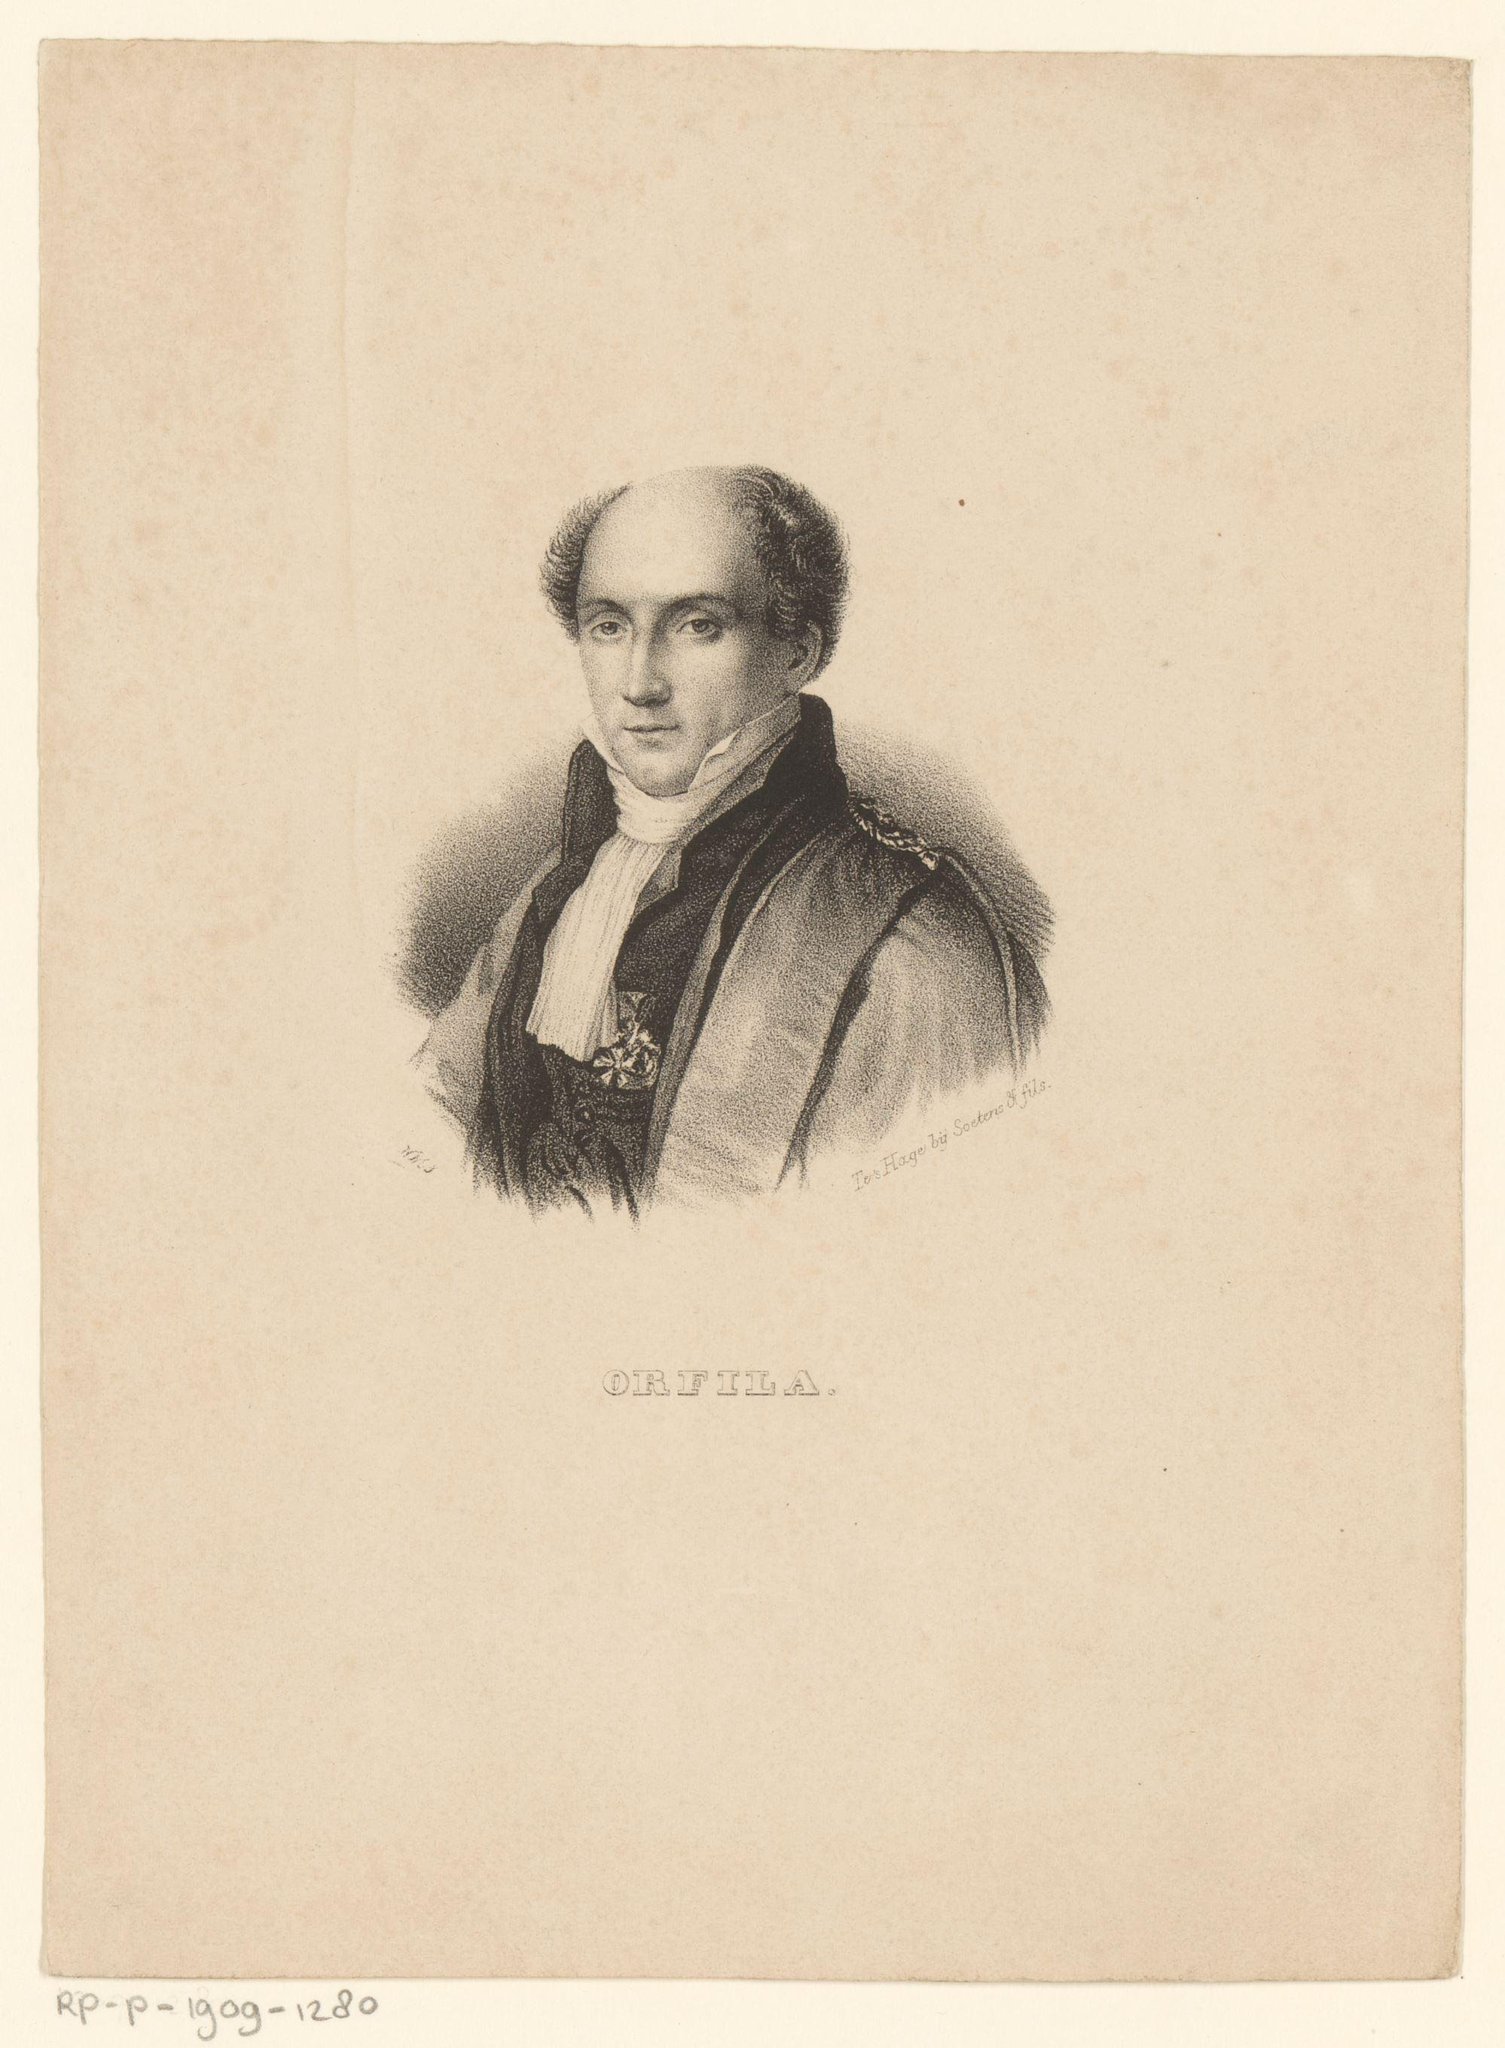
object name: print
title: Portret van Mathieu Orfila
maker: nicolaas martinus schild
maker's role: draughtsman, print maker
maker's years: 1822-1840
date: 1837-1840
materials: paper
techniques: lithograph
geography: the hague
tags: historical persons (+ (full) bust portrait)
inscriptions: collector's mark: Lugt 2228